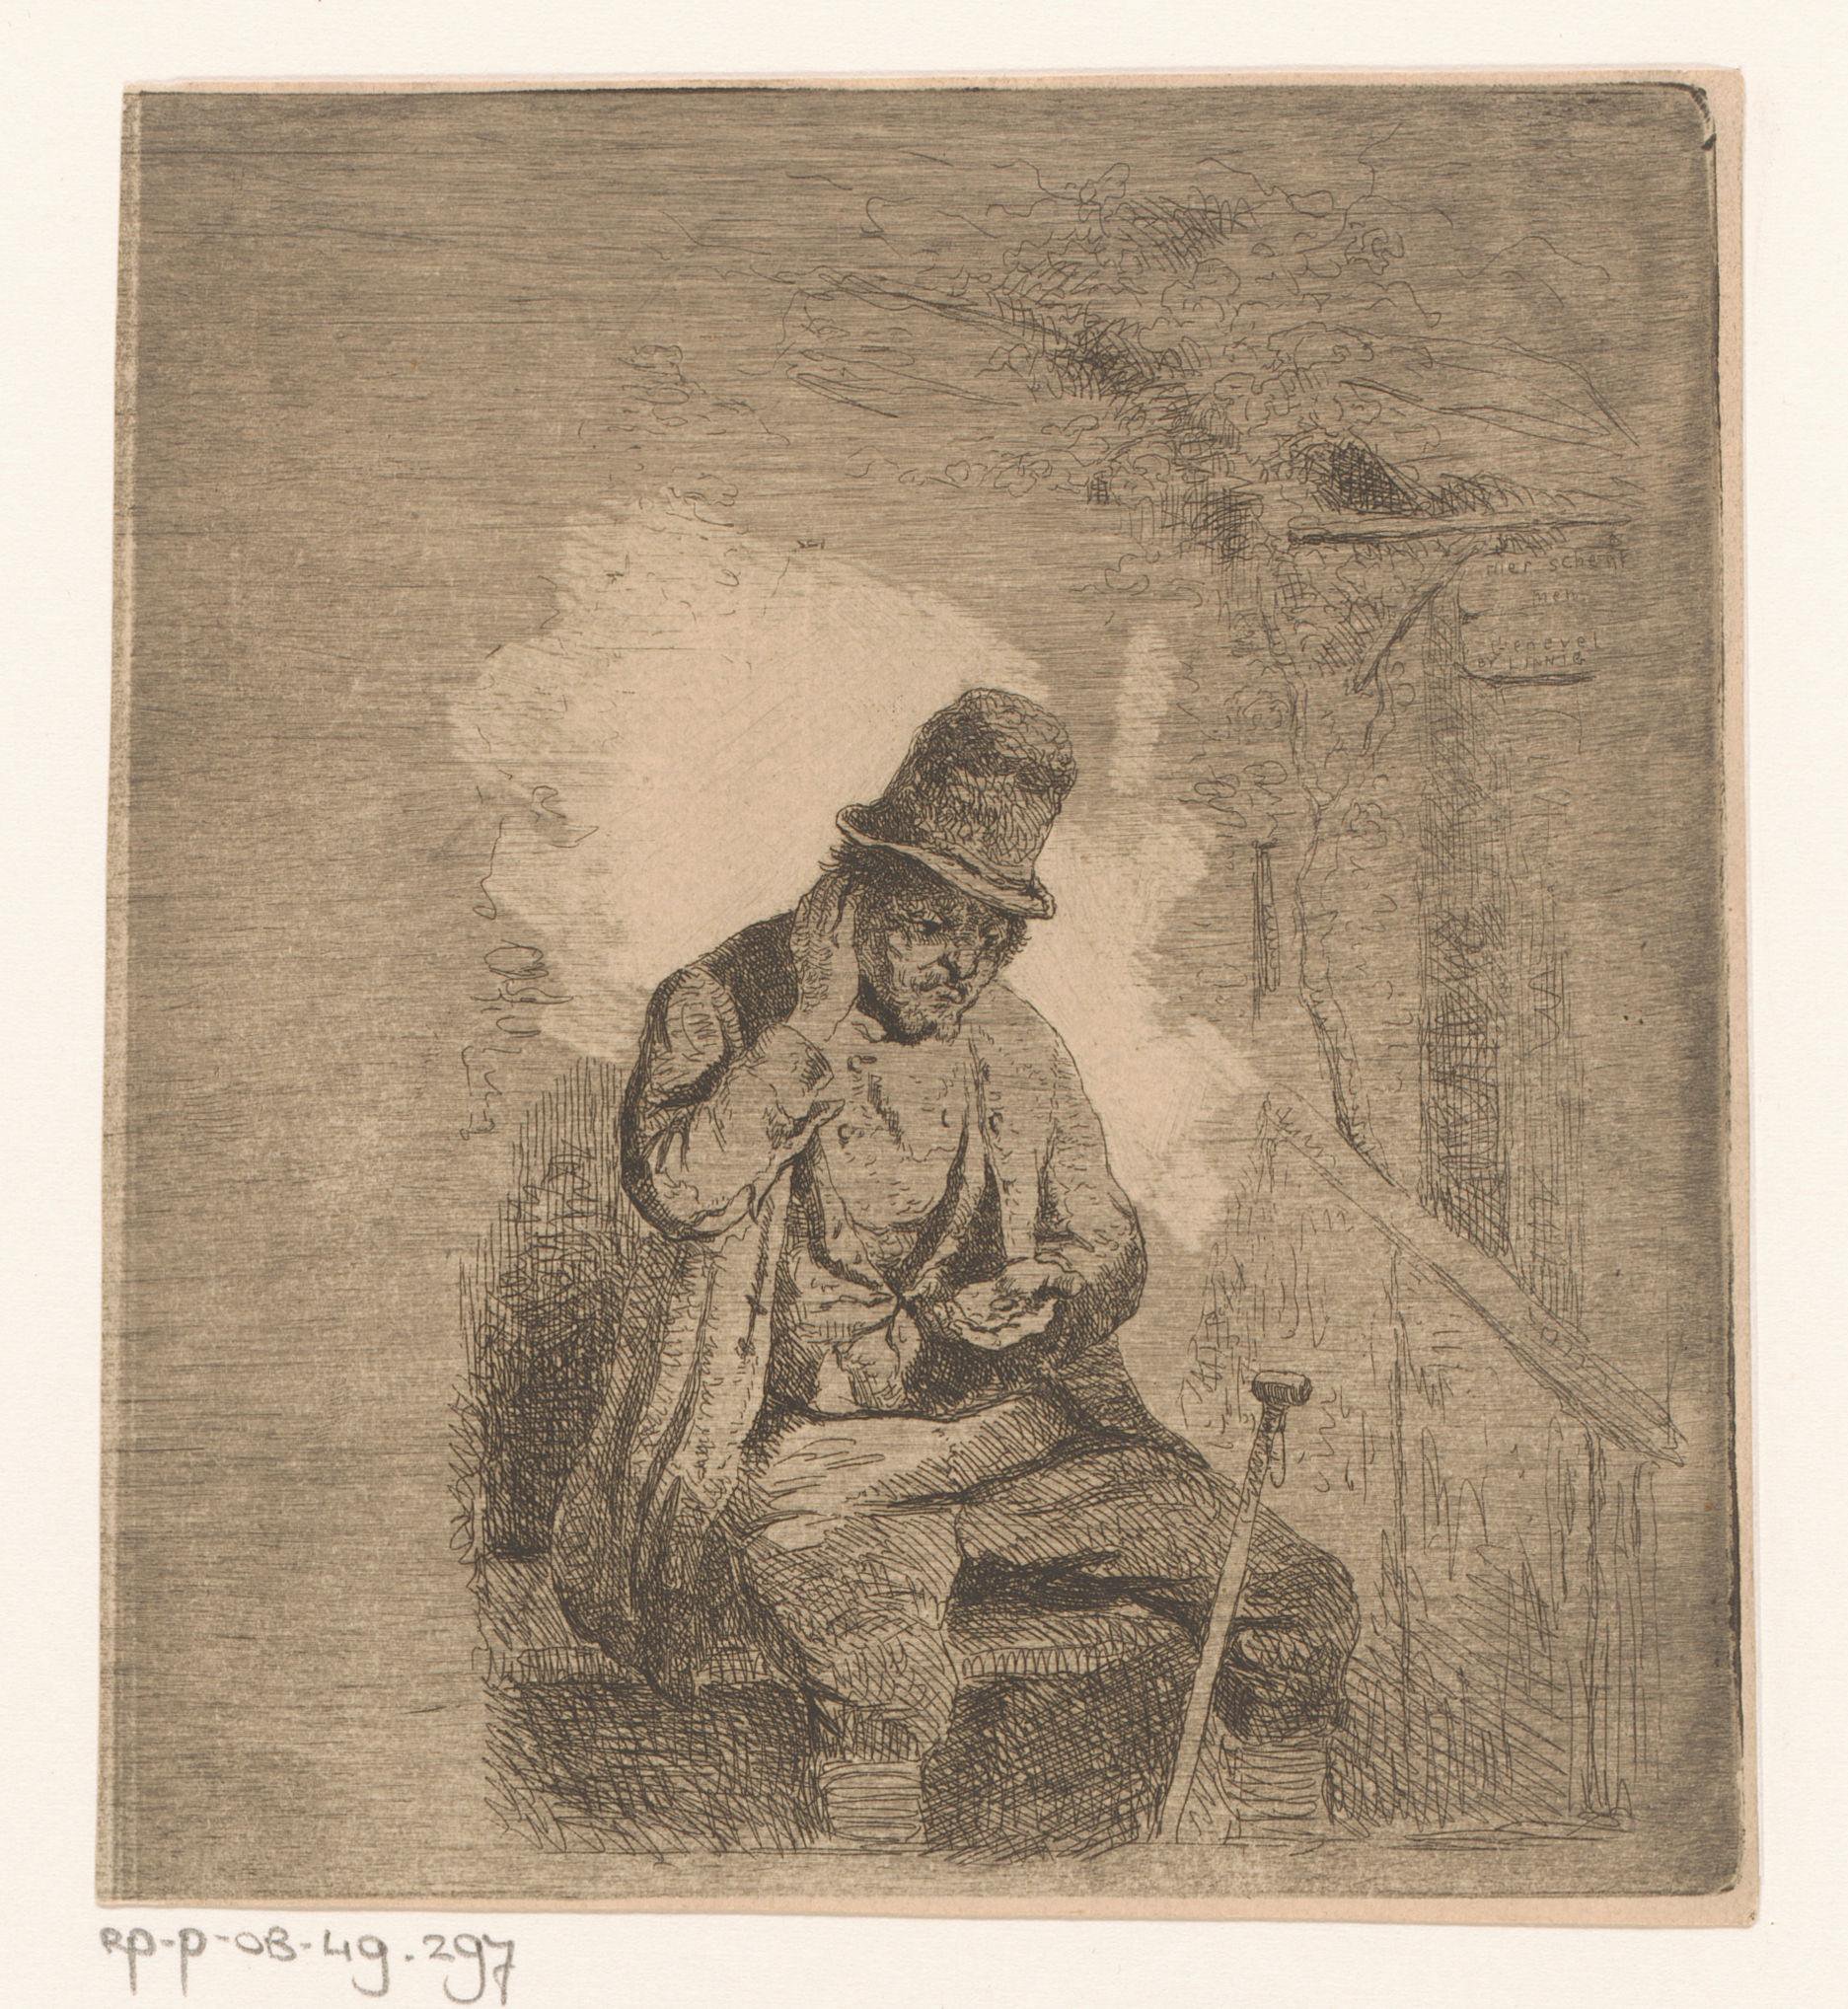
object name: print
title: Zittende man met munt in de hand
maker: willem linnig (i)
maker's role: print maker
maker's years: 1819-1885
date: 1846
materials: paper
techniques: etching, intaglio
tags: coin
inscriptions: collector's mark: Lugt 2228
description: Hoewel Hippert & Linnig deze prent toeschrijven aan Willem Linnig jr., is dat onwaarschijnlijk aangezien deze de prent dan op vierjarige leeftijd gemaakt zou moeten hebben.